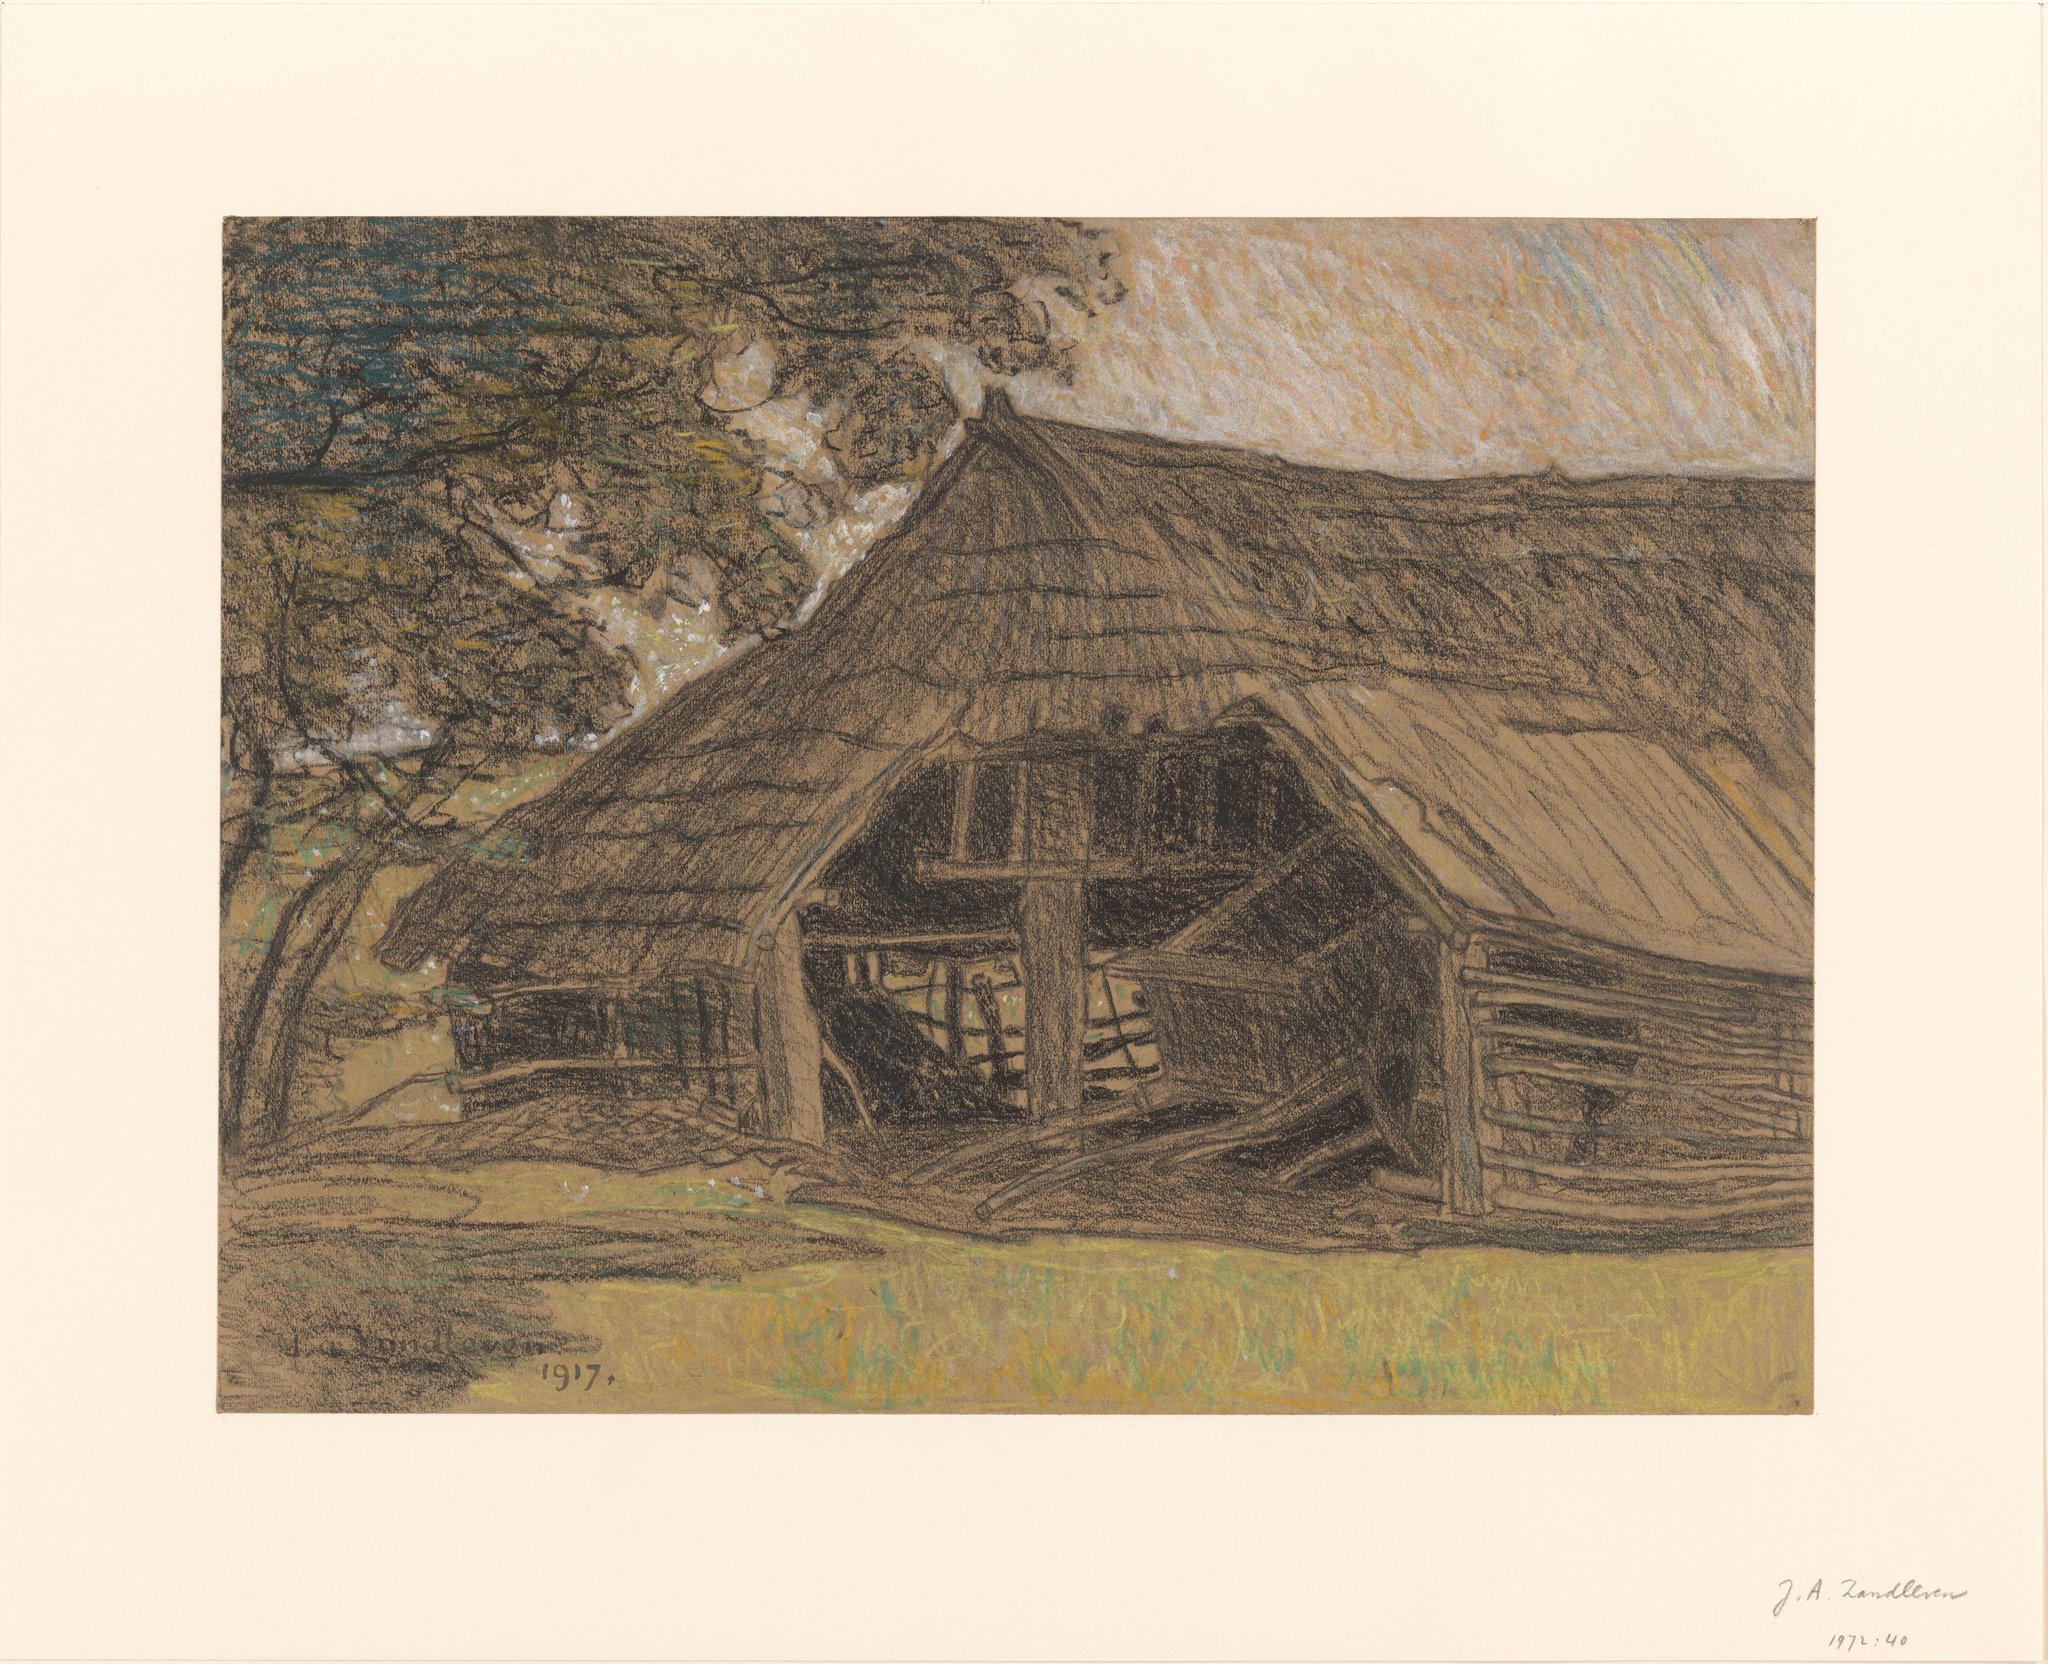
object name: drawing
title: Vervallen schuur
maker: jan adam zandleven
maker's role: draughtsman, painter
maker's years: 1868-1923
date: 1917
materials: chalk, paper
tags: barn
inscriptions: date: ‘1917’